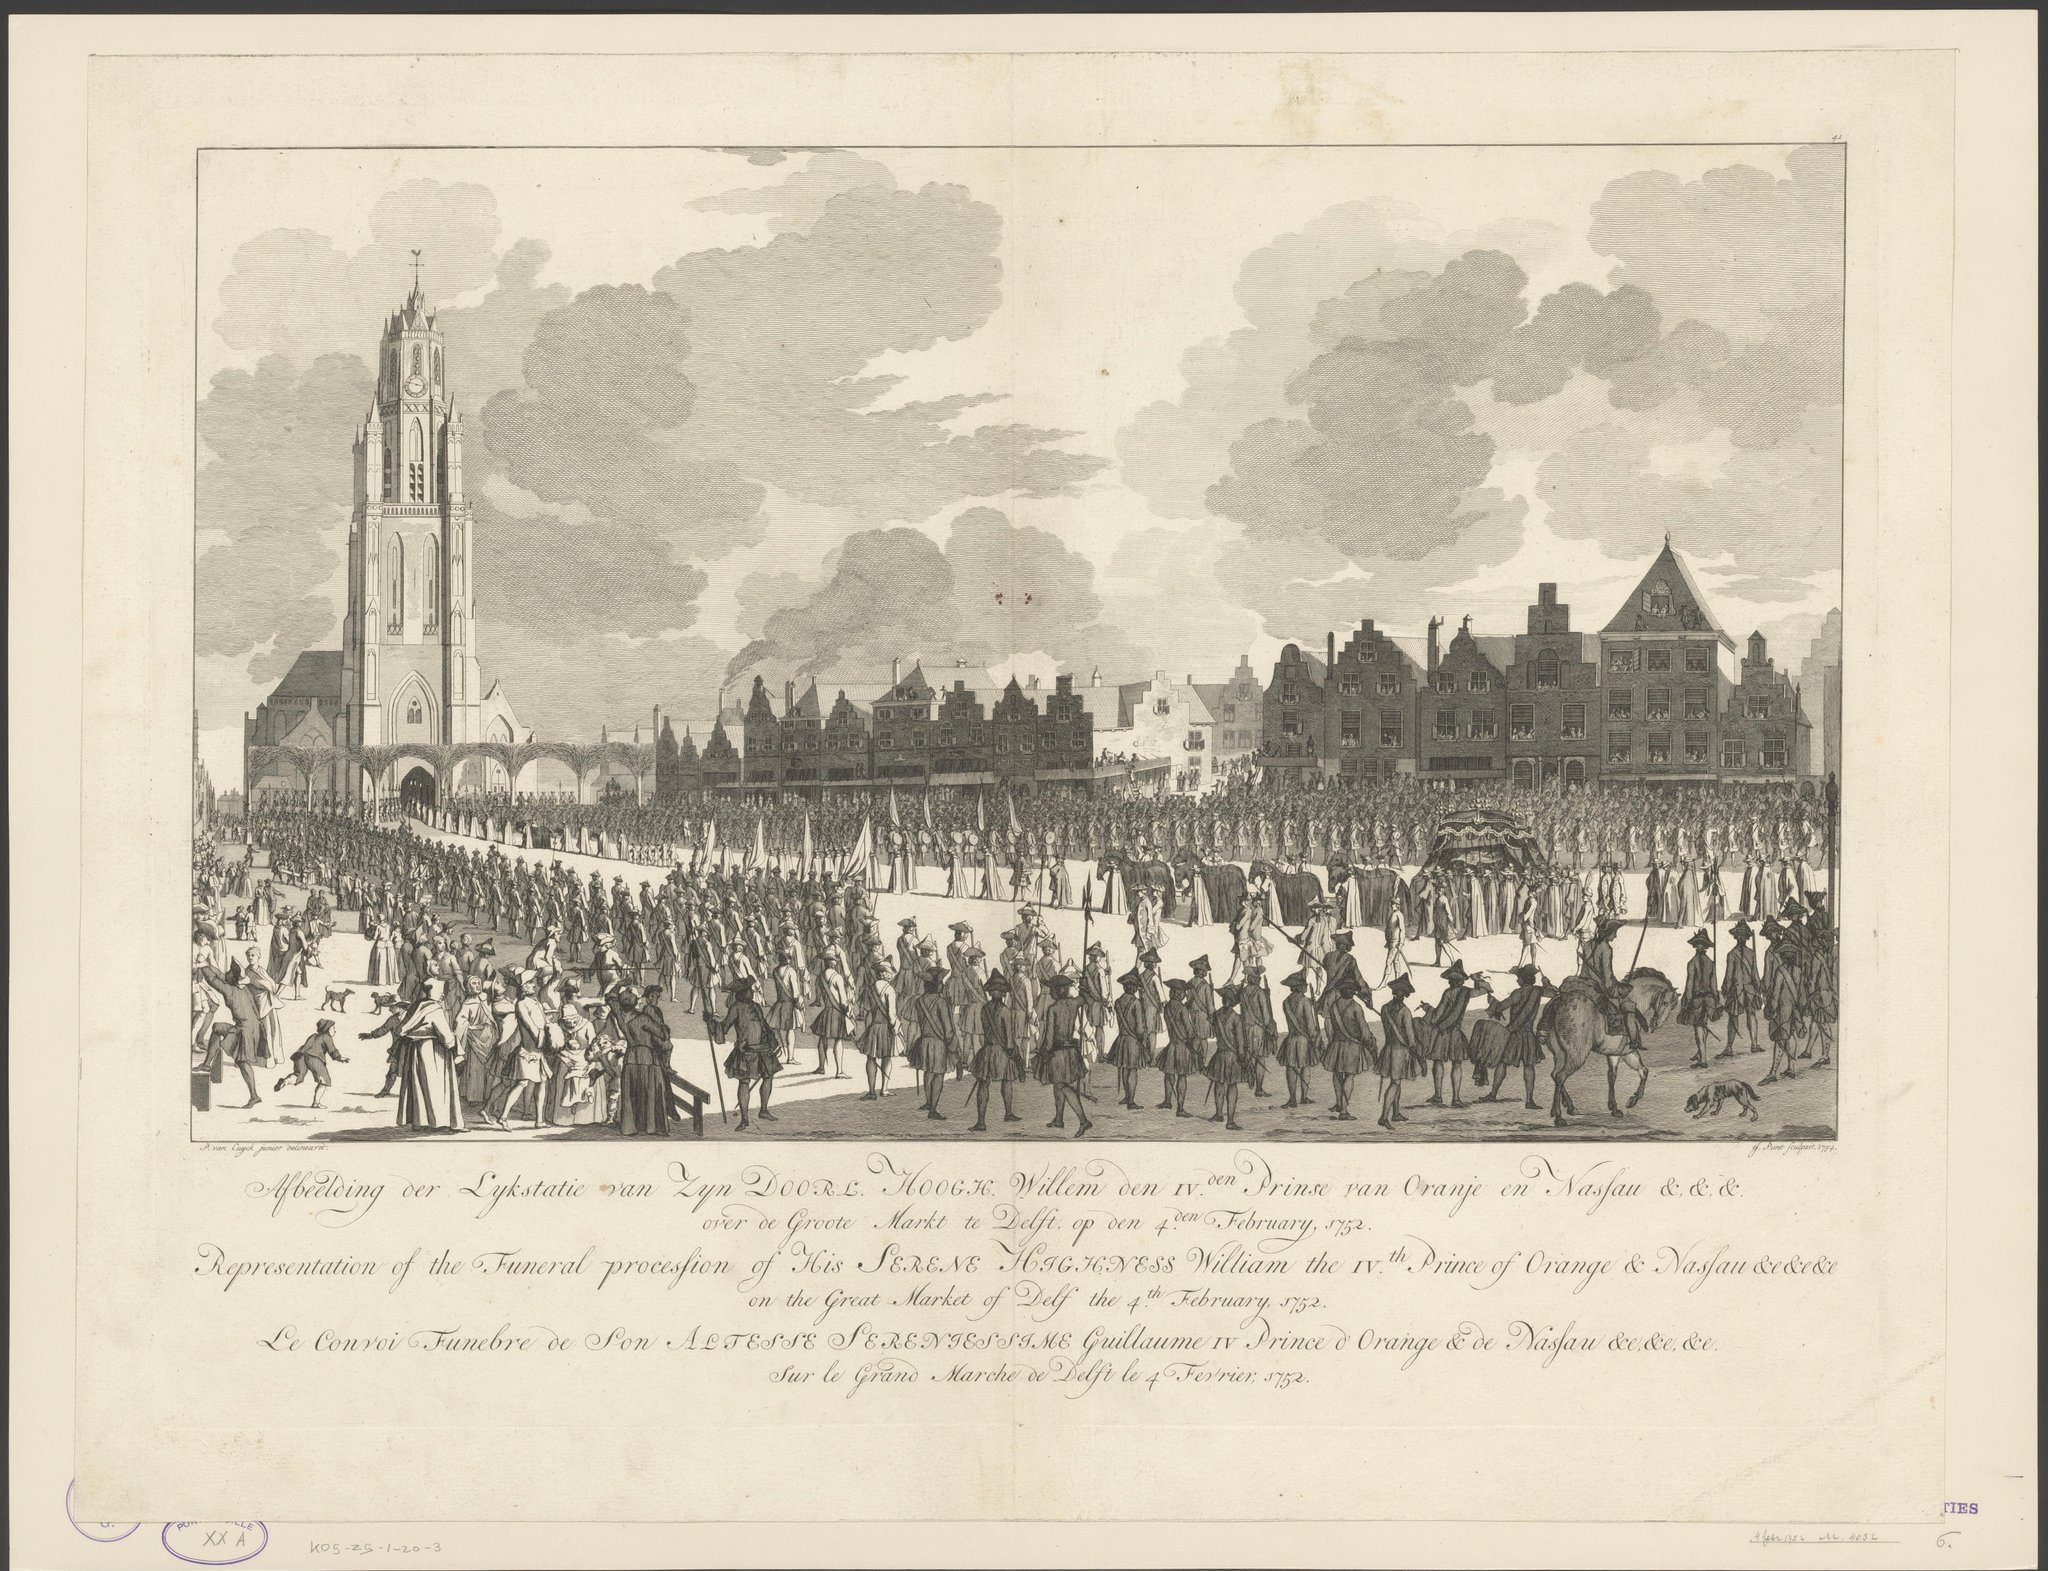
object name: print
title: Afbeelding der Lykstatie van Zyn Doorl. Hoogh. Willem den IV.den Prinse van Oranje en Nassau &,&,&. over de Groote Markt te Delft, op den 4.den February 1752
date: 1754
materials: paper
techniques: engraving, etching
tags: the hague, willem iv (prins van oranje-nassau), cortege, funeral procession, delft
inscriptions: stamp, stamp, collector's mark: Lugt 1641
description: Aankomst van de rouwstoet met de lijkwagen op de Grote Markt te Delft en de intocht in de Nieuwe Kerk. In de marge het onderschrift in Nederlands, Frans en Engels. Onderdeel van een serie van 41 platen van de begrafenisstoet van stadhouder Willem IV te Delft op 4 februari 1752. Genummerd rechtsboven: 41. Onderwerpsrubrieken binnen de Atlas Zeden en Gewoonten: Zeden en Gewoonten in Engeren Zin, Des menschen beging, midden en einde, Vorstelijke lijkstaties.